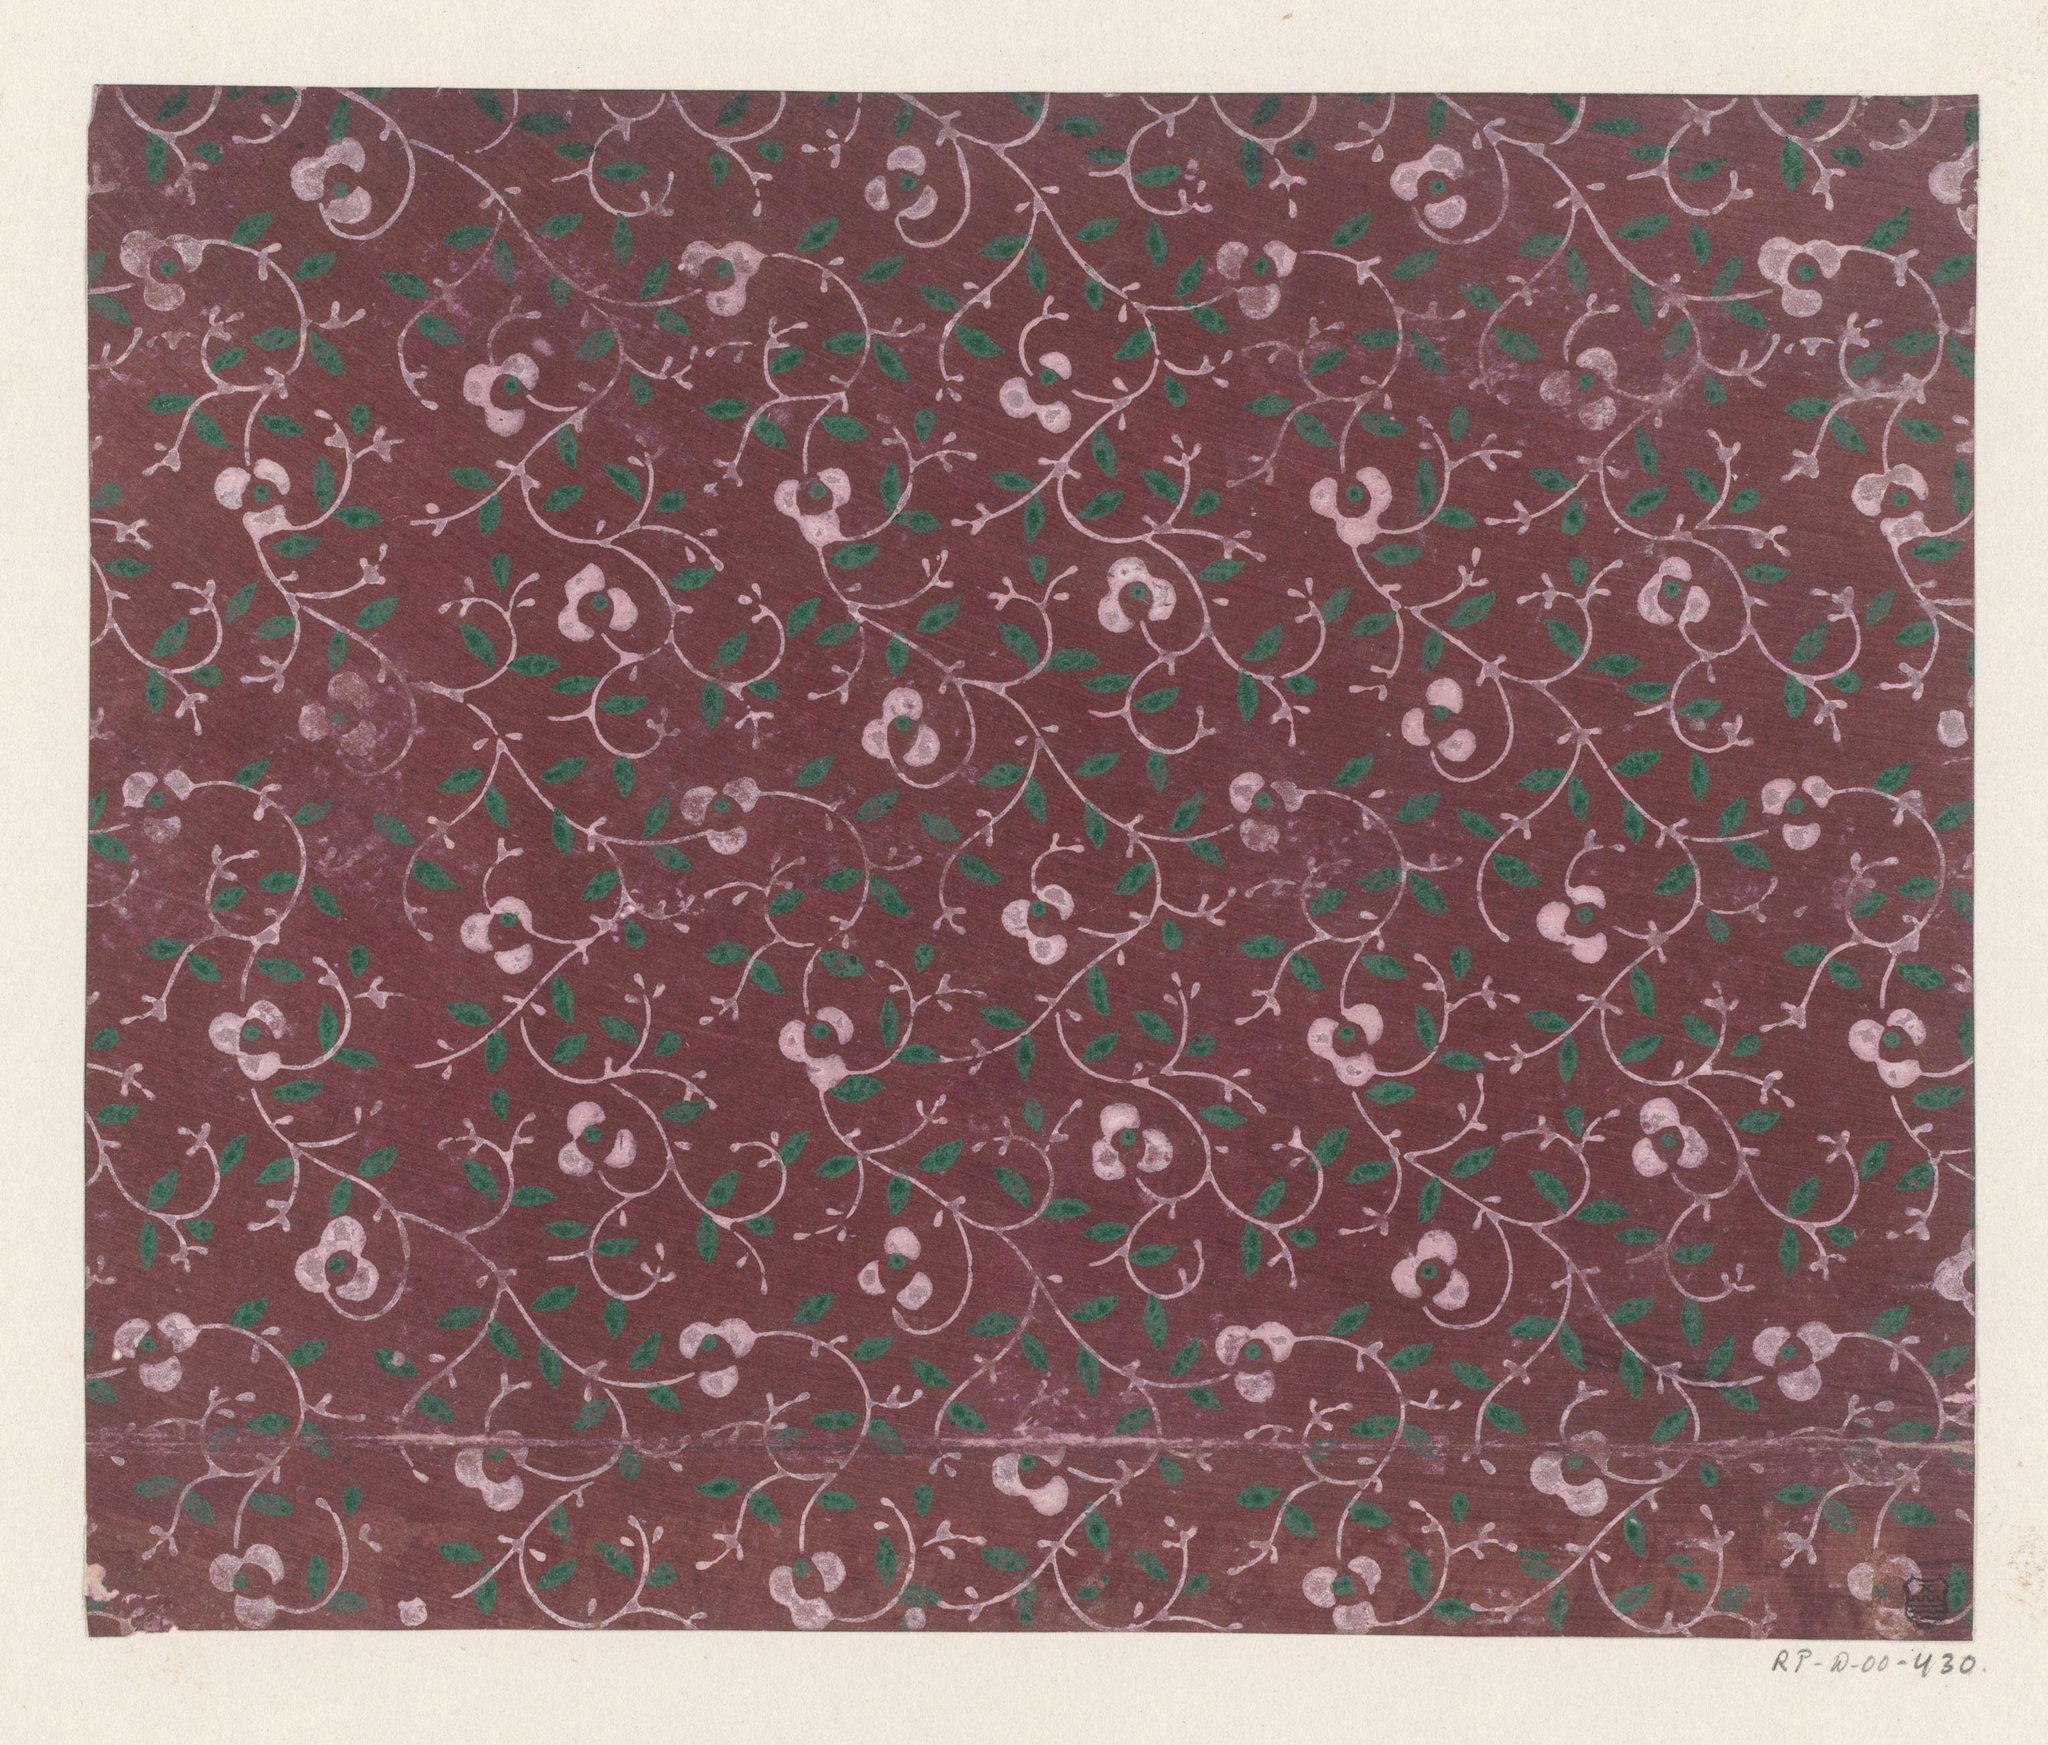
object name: printed paper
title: Blad met strooipatroon van ranken met bloemen en blaadjes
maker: Anonymous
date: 1700-1850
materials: paper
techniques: printing block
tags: ornament derived from plant forms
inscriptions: collector's mark: Lugt 2760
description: Blad met strooipatroon van ranken met bloemen en blaadjes.